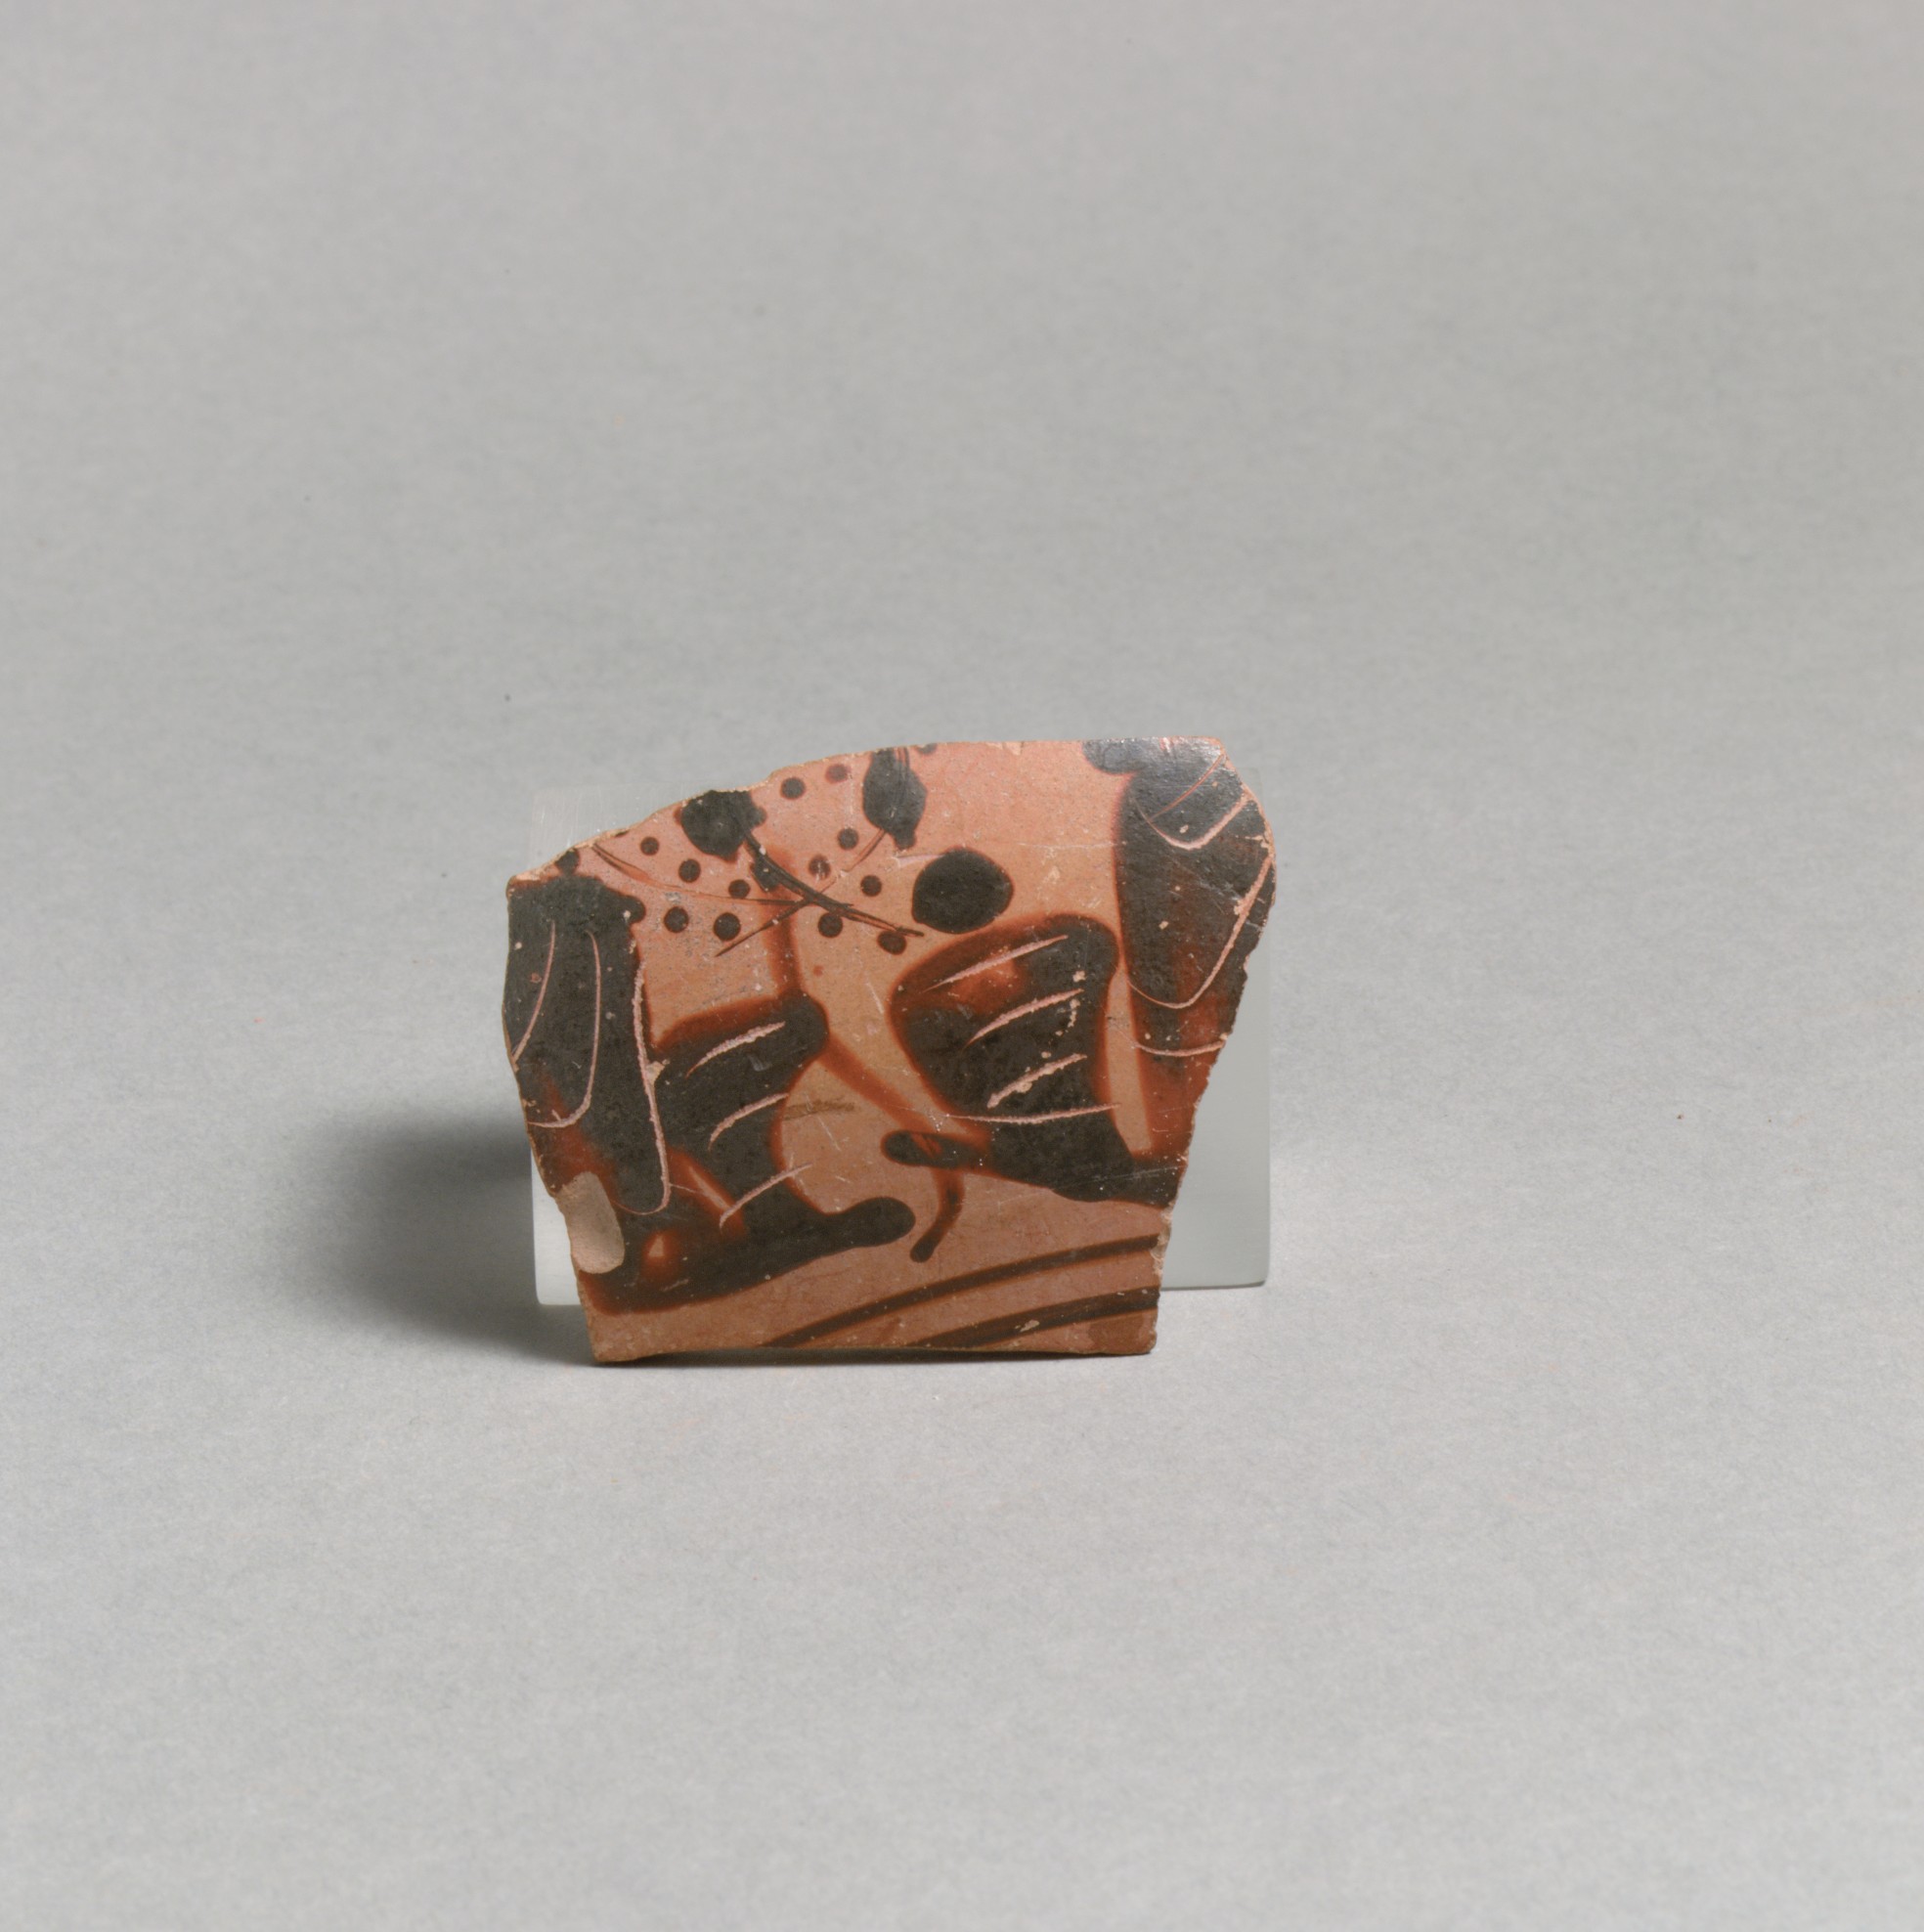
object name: kylix, eye cup fragment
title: Kylix, eye-cup fragment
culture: greek, attic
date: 500-475 BCE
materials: terracotta